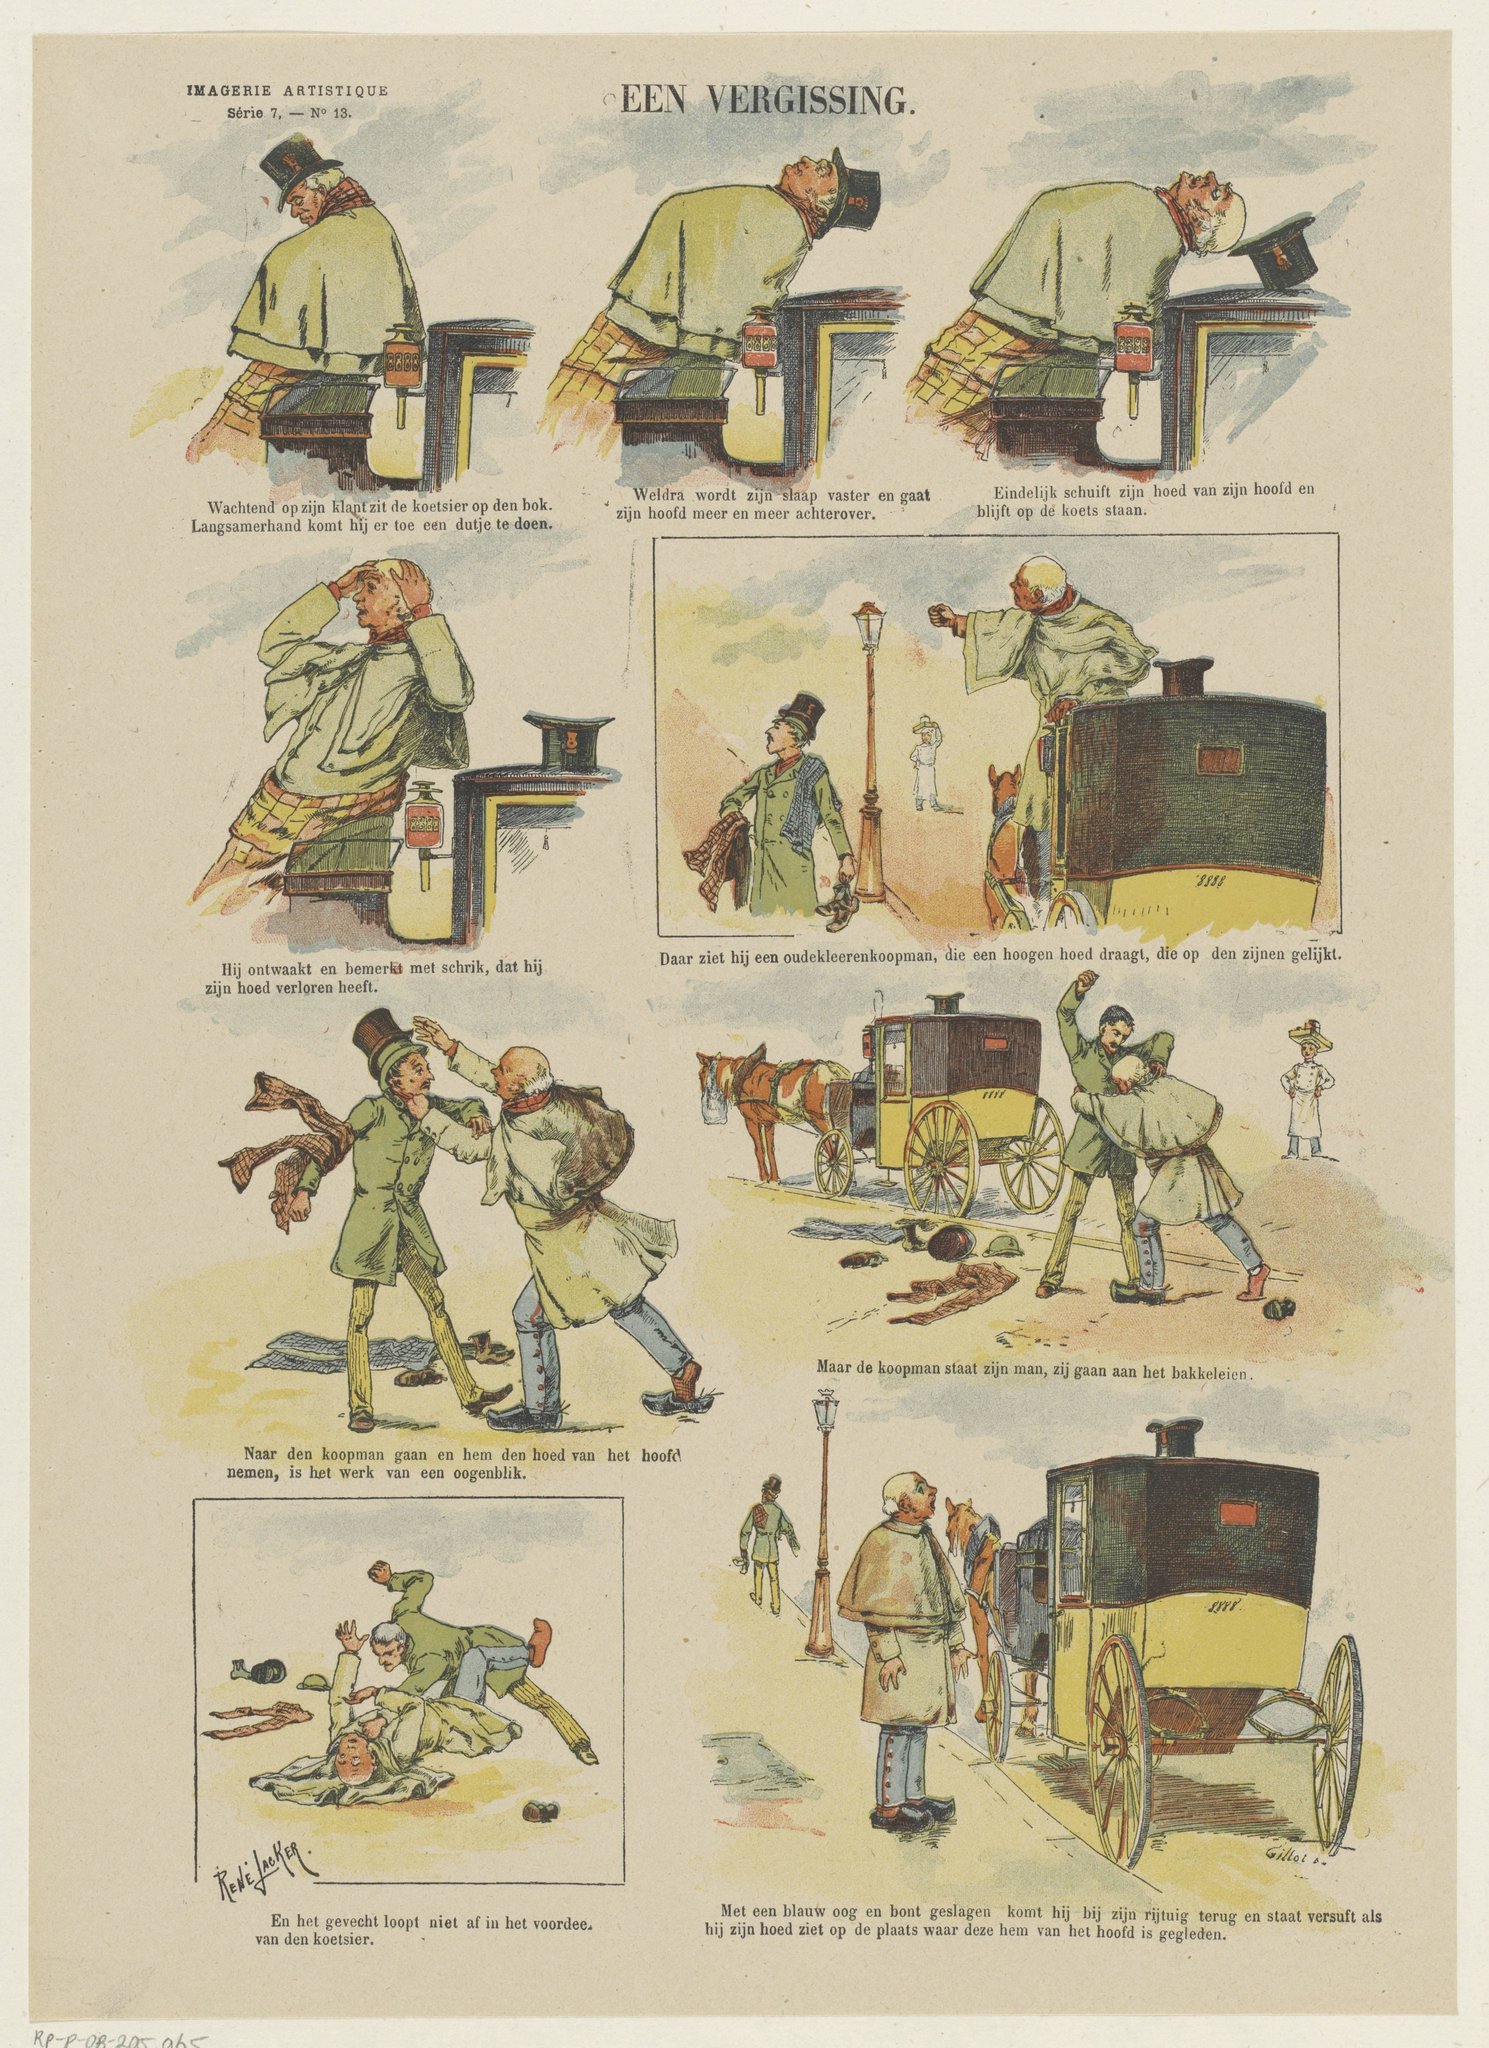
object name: popular print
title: Imagerie Artistique / Série 7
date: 1876-1890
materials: paper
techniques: lithograph, letterpress printing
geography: paris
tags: four-wheeled, animal-drawn vehicle, e.g.: cab, carriage, coach, tales and fairy tales, fighting, head-gear: top hat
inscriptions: collector's mark: Lugt 2760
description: Blad met 9 voorstellingen van een koetsier die in slaap valt en denkt dat een koopman zijn hoed heeft gestolen. De hoed blijkt gewoon op de wagen te staan. Onder elke voorstelling een onderschrift. Genummerd linksboven: Série 7. - No. 13.